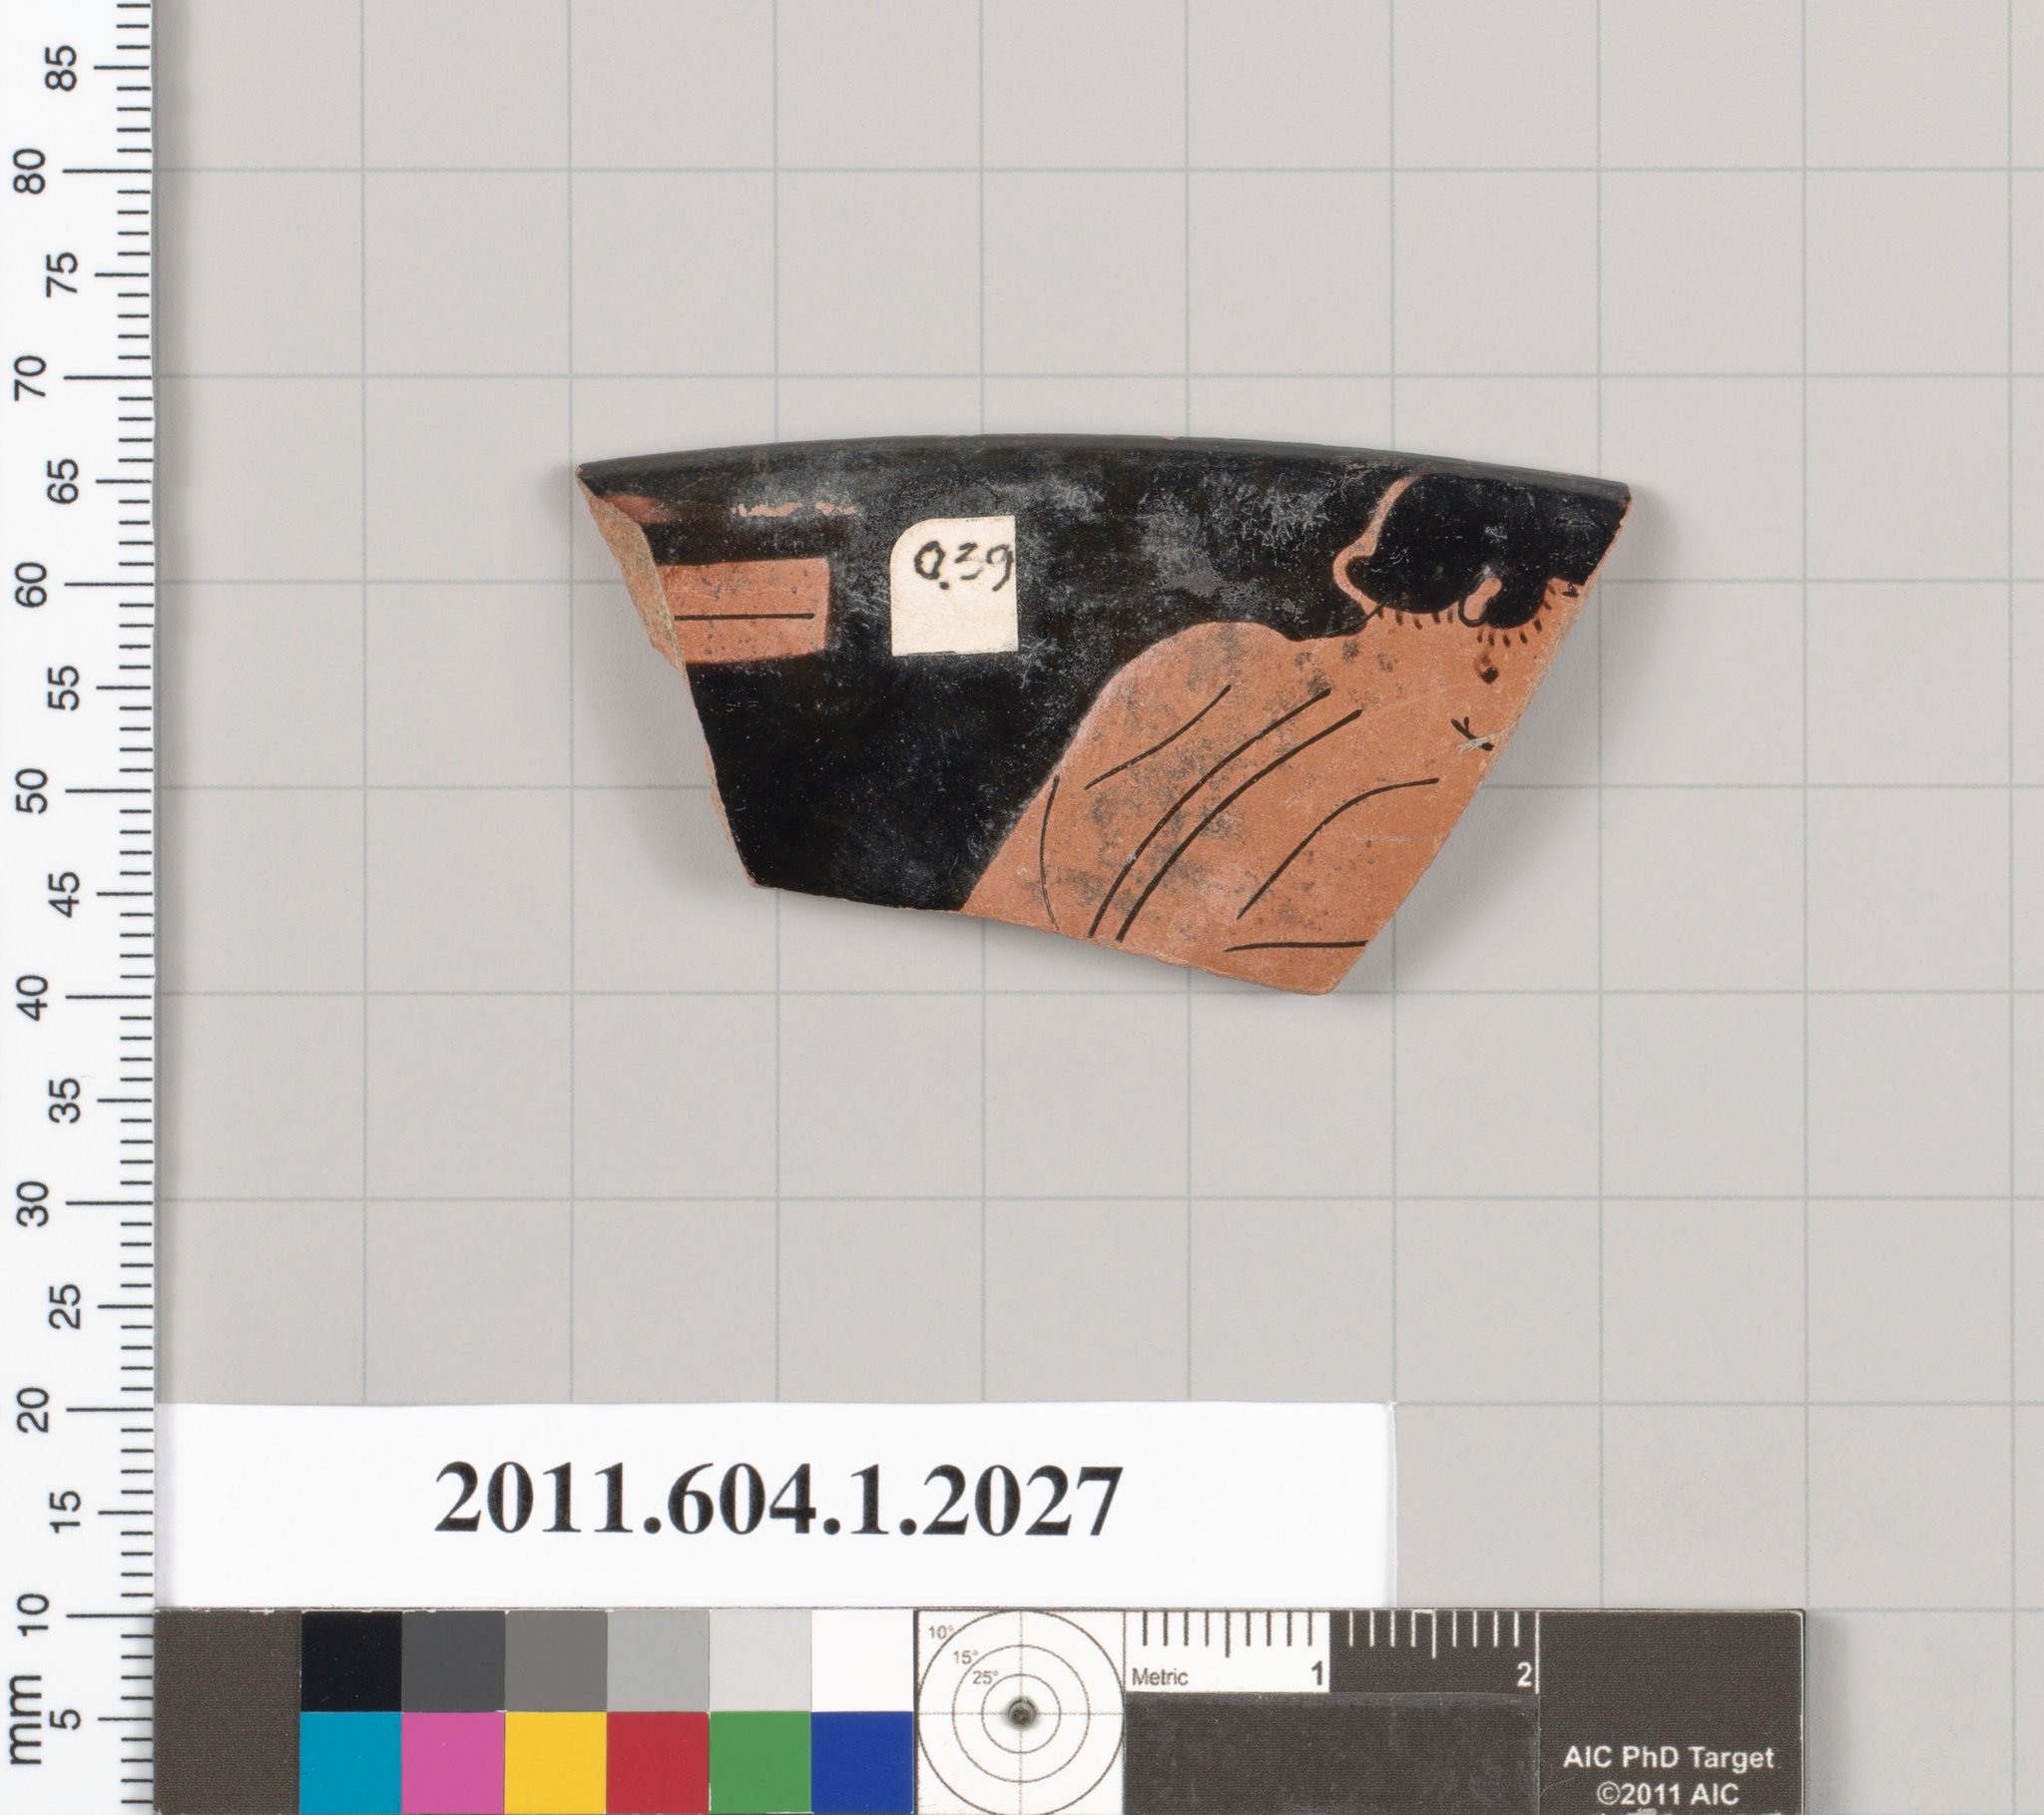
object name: kylix fragment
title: Terracotta rim fragment of a kylix (drinking cup)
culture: greek, attic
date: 475-451 BCE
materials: terracotta